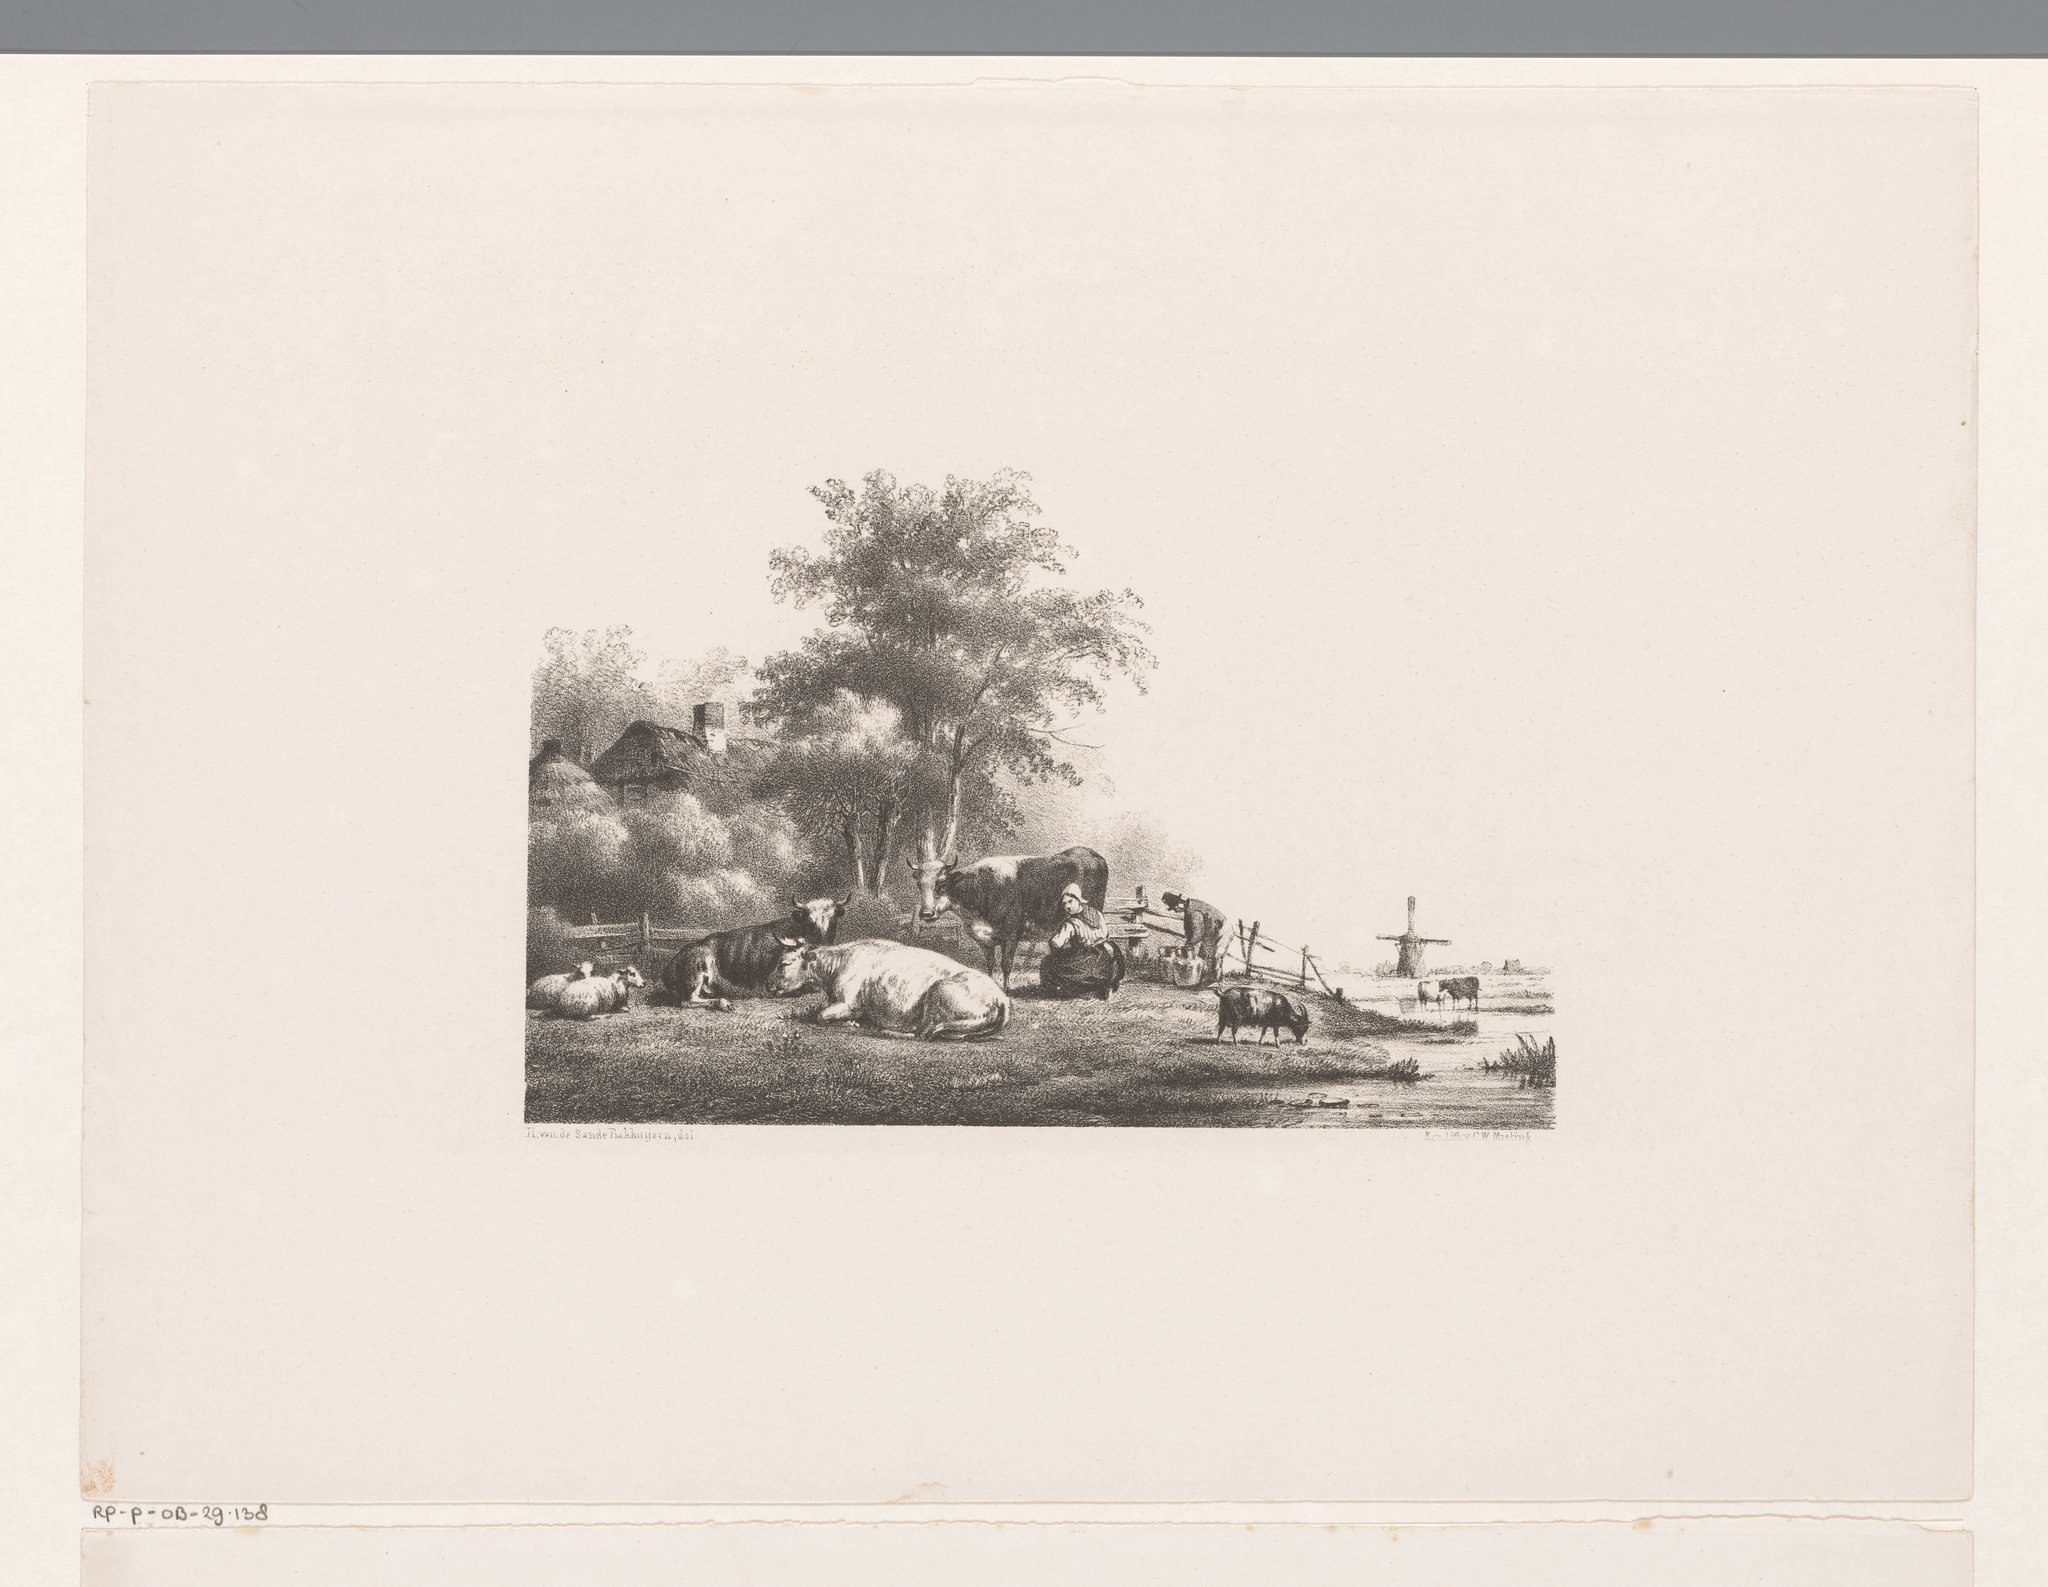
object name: print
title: Landschap met boerderij, kudde en melkende boerin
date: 1830-1865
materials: paper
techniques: lithograph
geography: the hague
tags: cattle, windmill, farm or solitary house in landscape, milking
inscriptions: collector's mark: Lugt 2228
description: Rechts van de boerin staat de boer met twee melkkruiken. Rechts een windmolen.